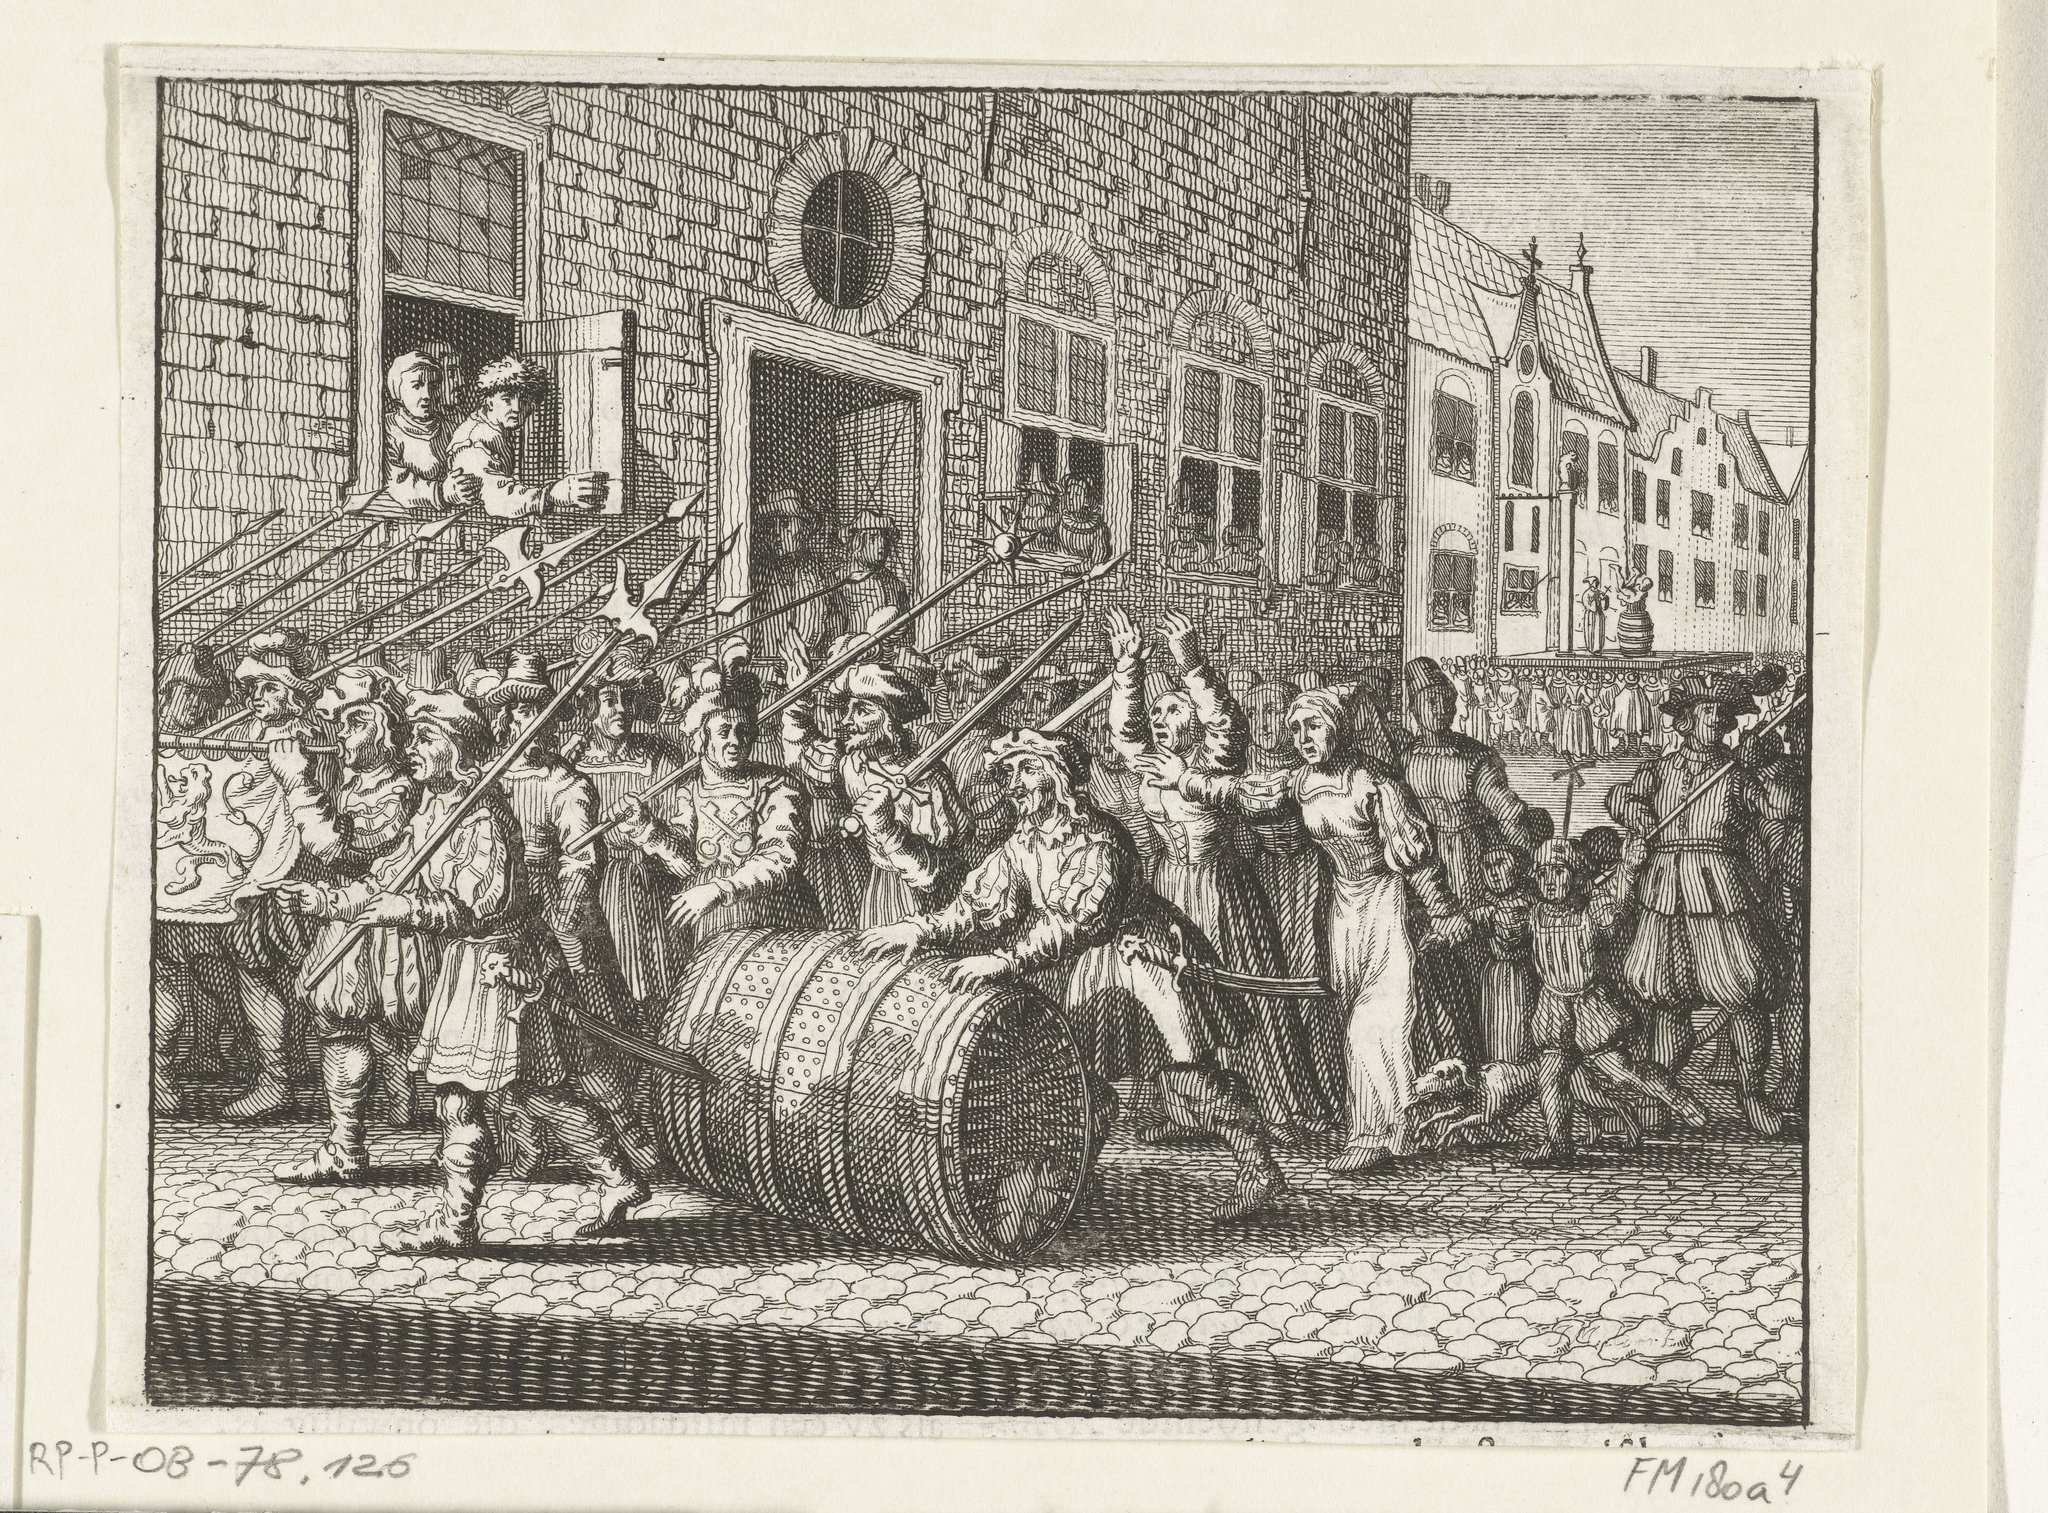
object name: history print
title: Strafoefening aan Gerard van Velzen, 1296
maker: Anonymous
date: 1662-1664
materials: paper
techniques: etching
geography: northern netherlands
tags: floris v (graaf van holland en zeeland), death penalty, execution, law and jurisprudence (+ execution), netherlands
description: Illustratie voor: A. Montanus, Beschrijvinge der eerste inwoonders van Aemstellandt, Marcus Willemsz. Doornik, Amsterdam 1664. Uit het boek geknipt, met tekst op de achterzijde.